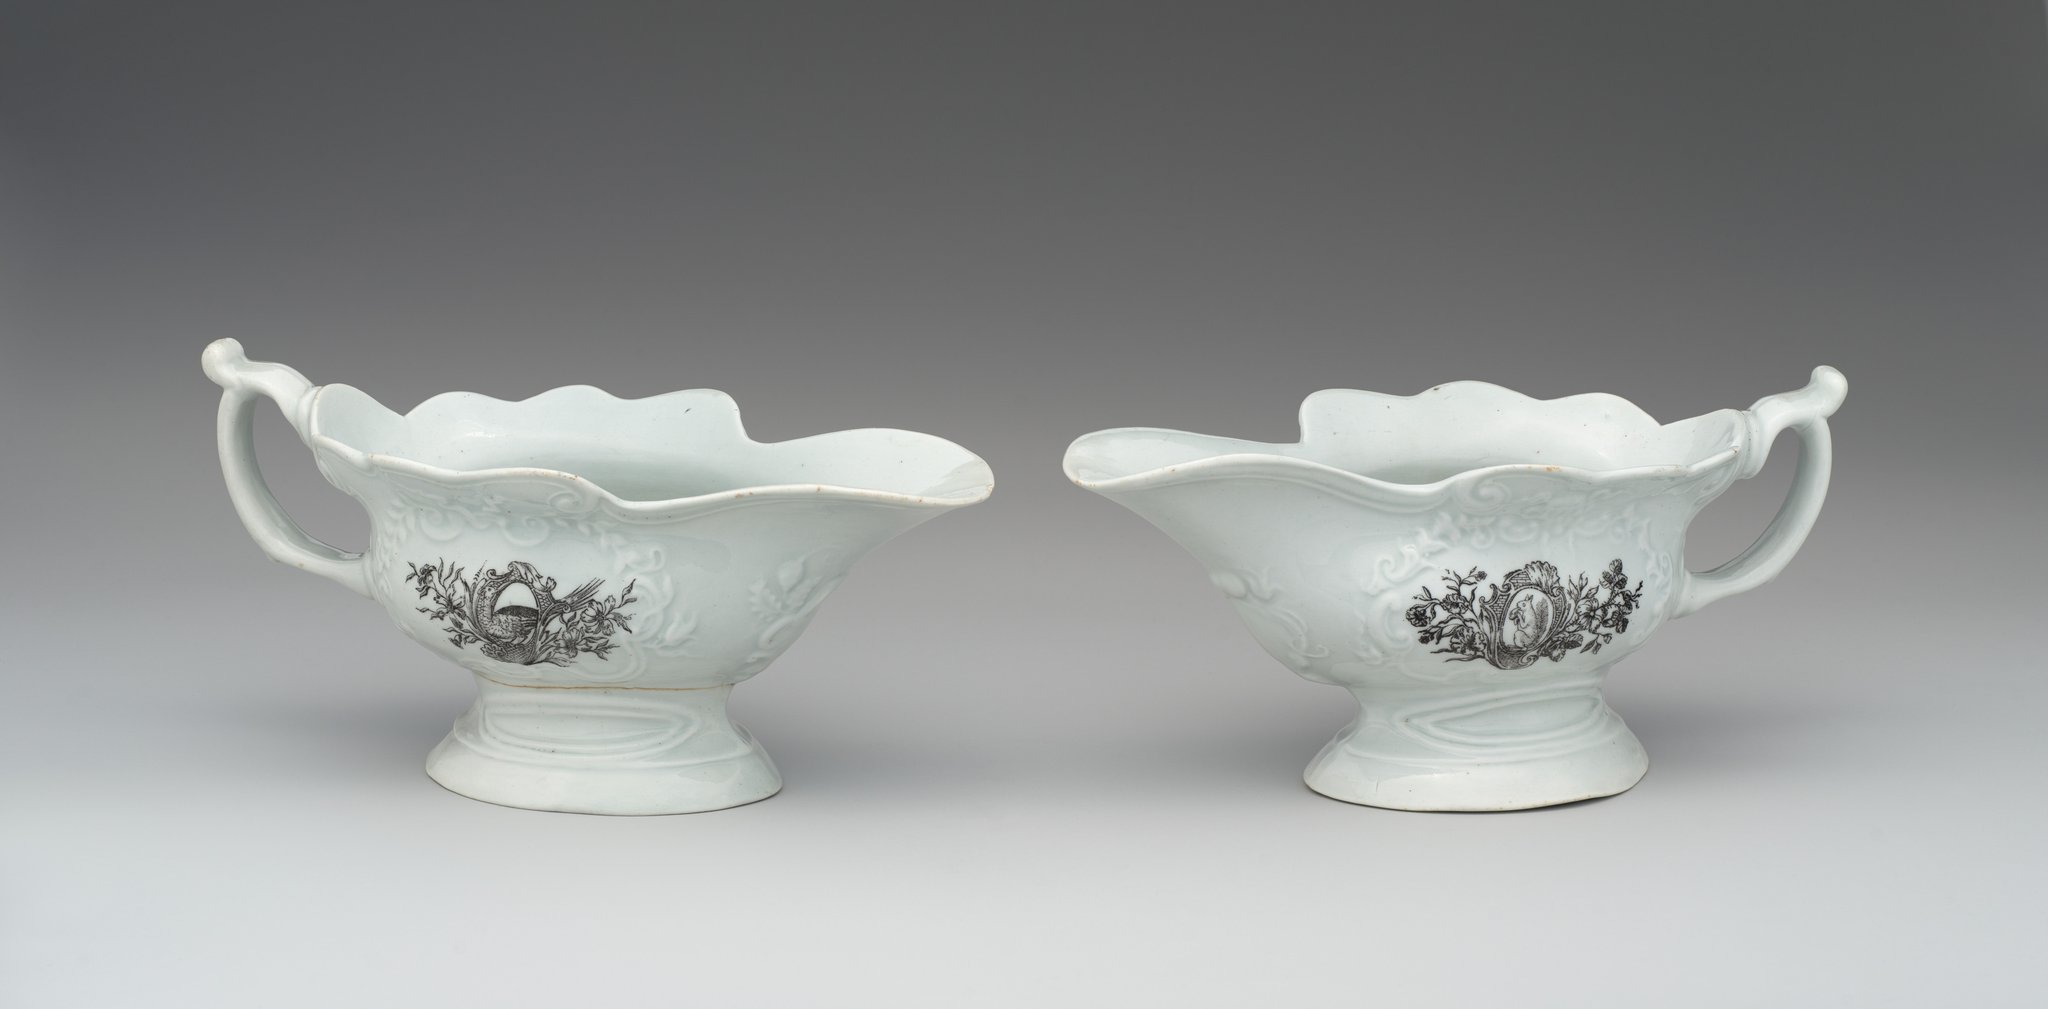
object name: sauceboat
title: Pair of sauceboats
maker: worcester factory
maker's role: factory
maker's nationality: british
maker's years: 1751-2008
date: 1775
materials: porcelain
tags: pheasants,squirrels